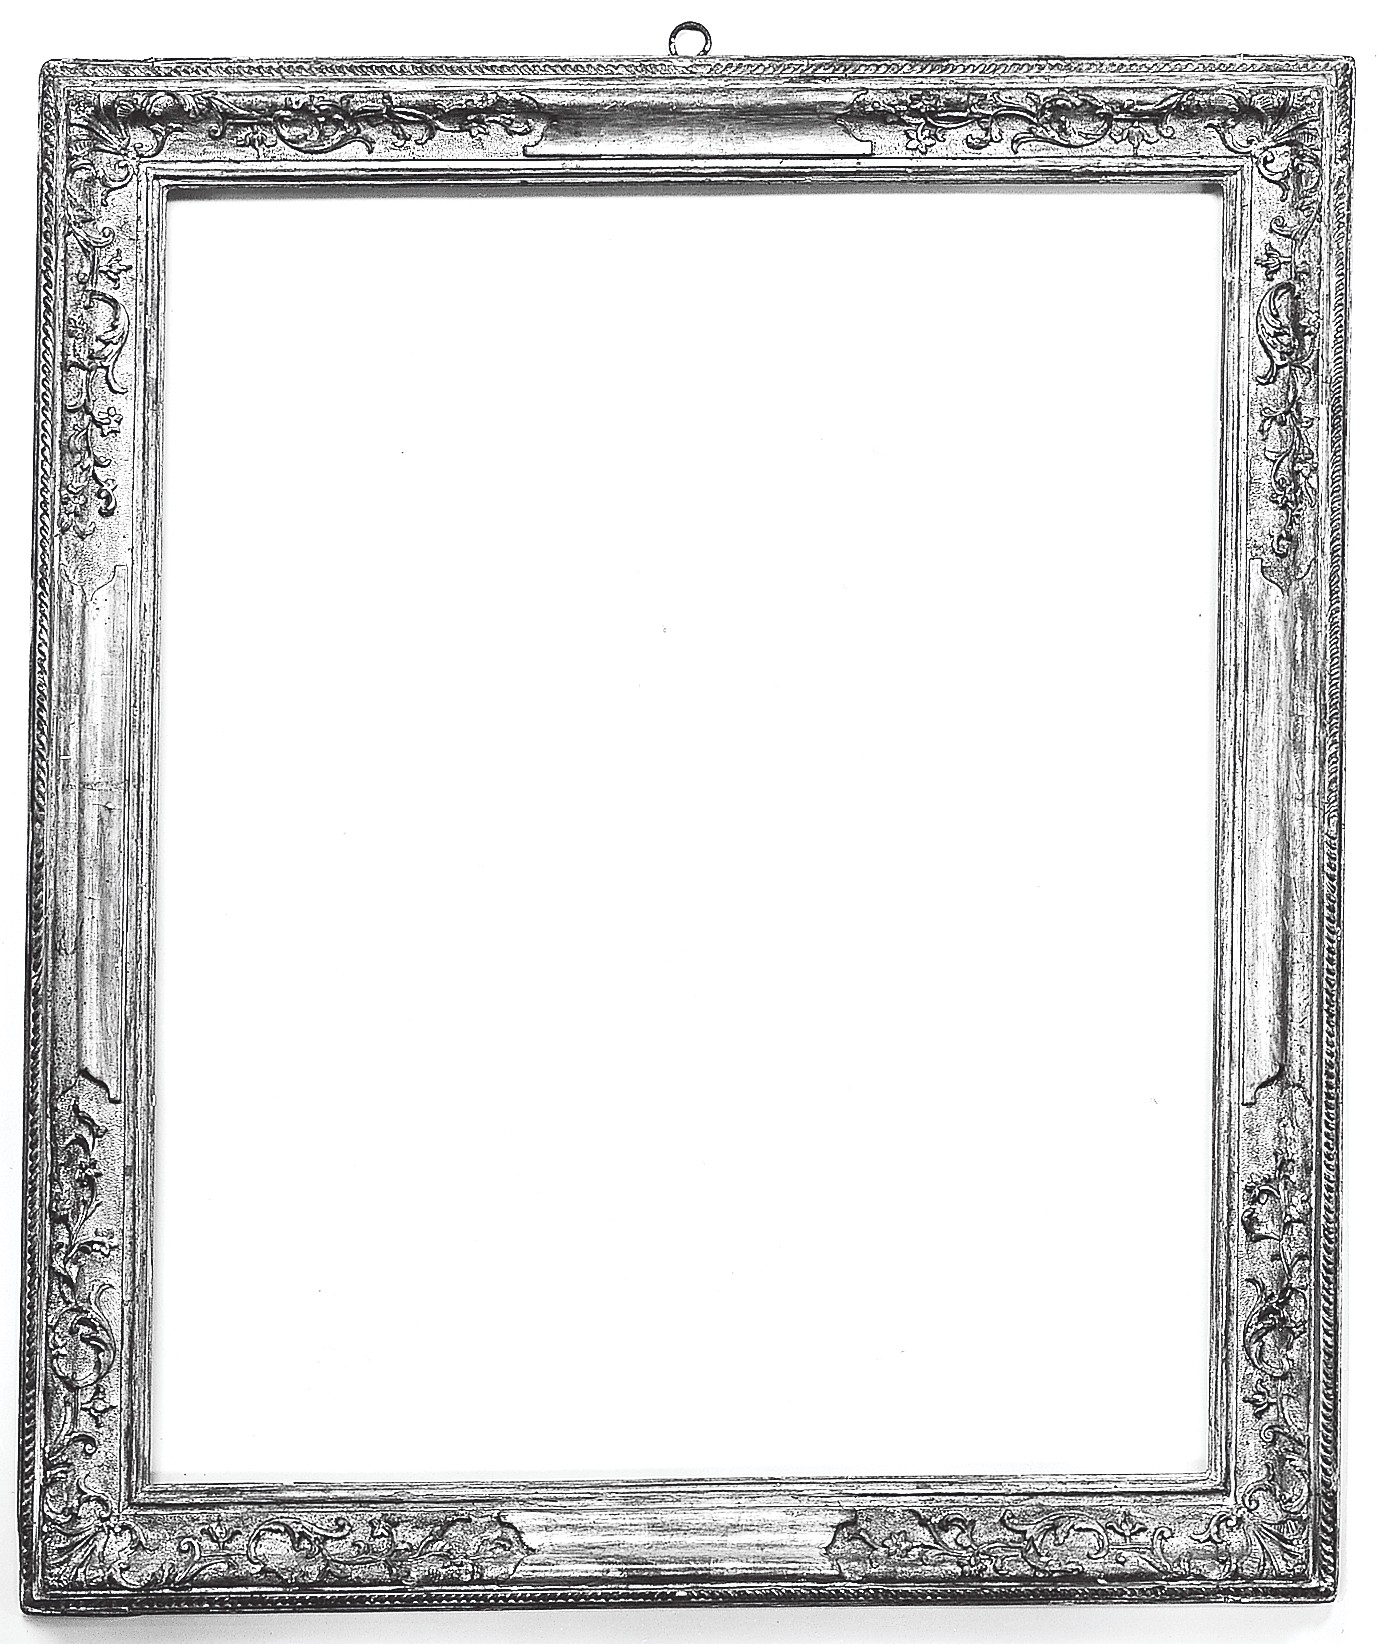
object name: frame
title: Canaletto frame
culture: italian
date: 1720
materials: wood